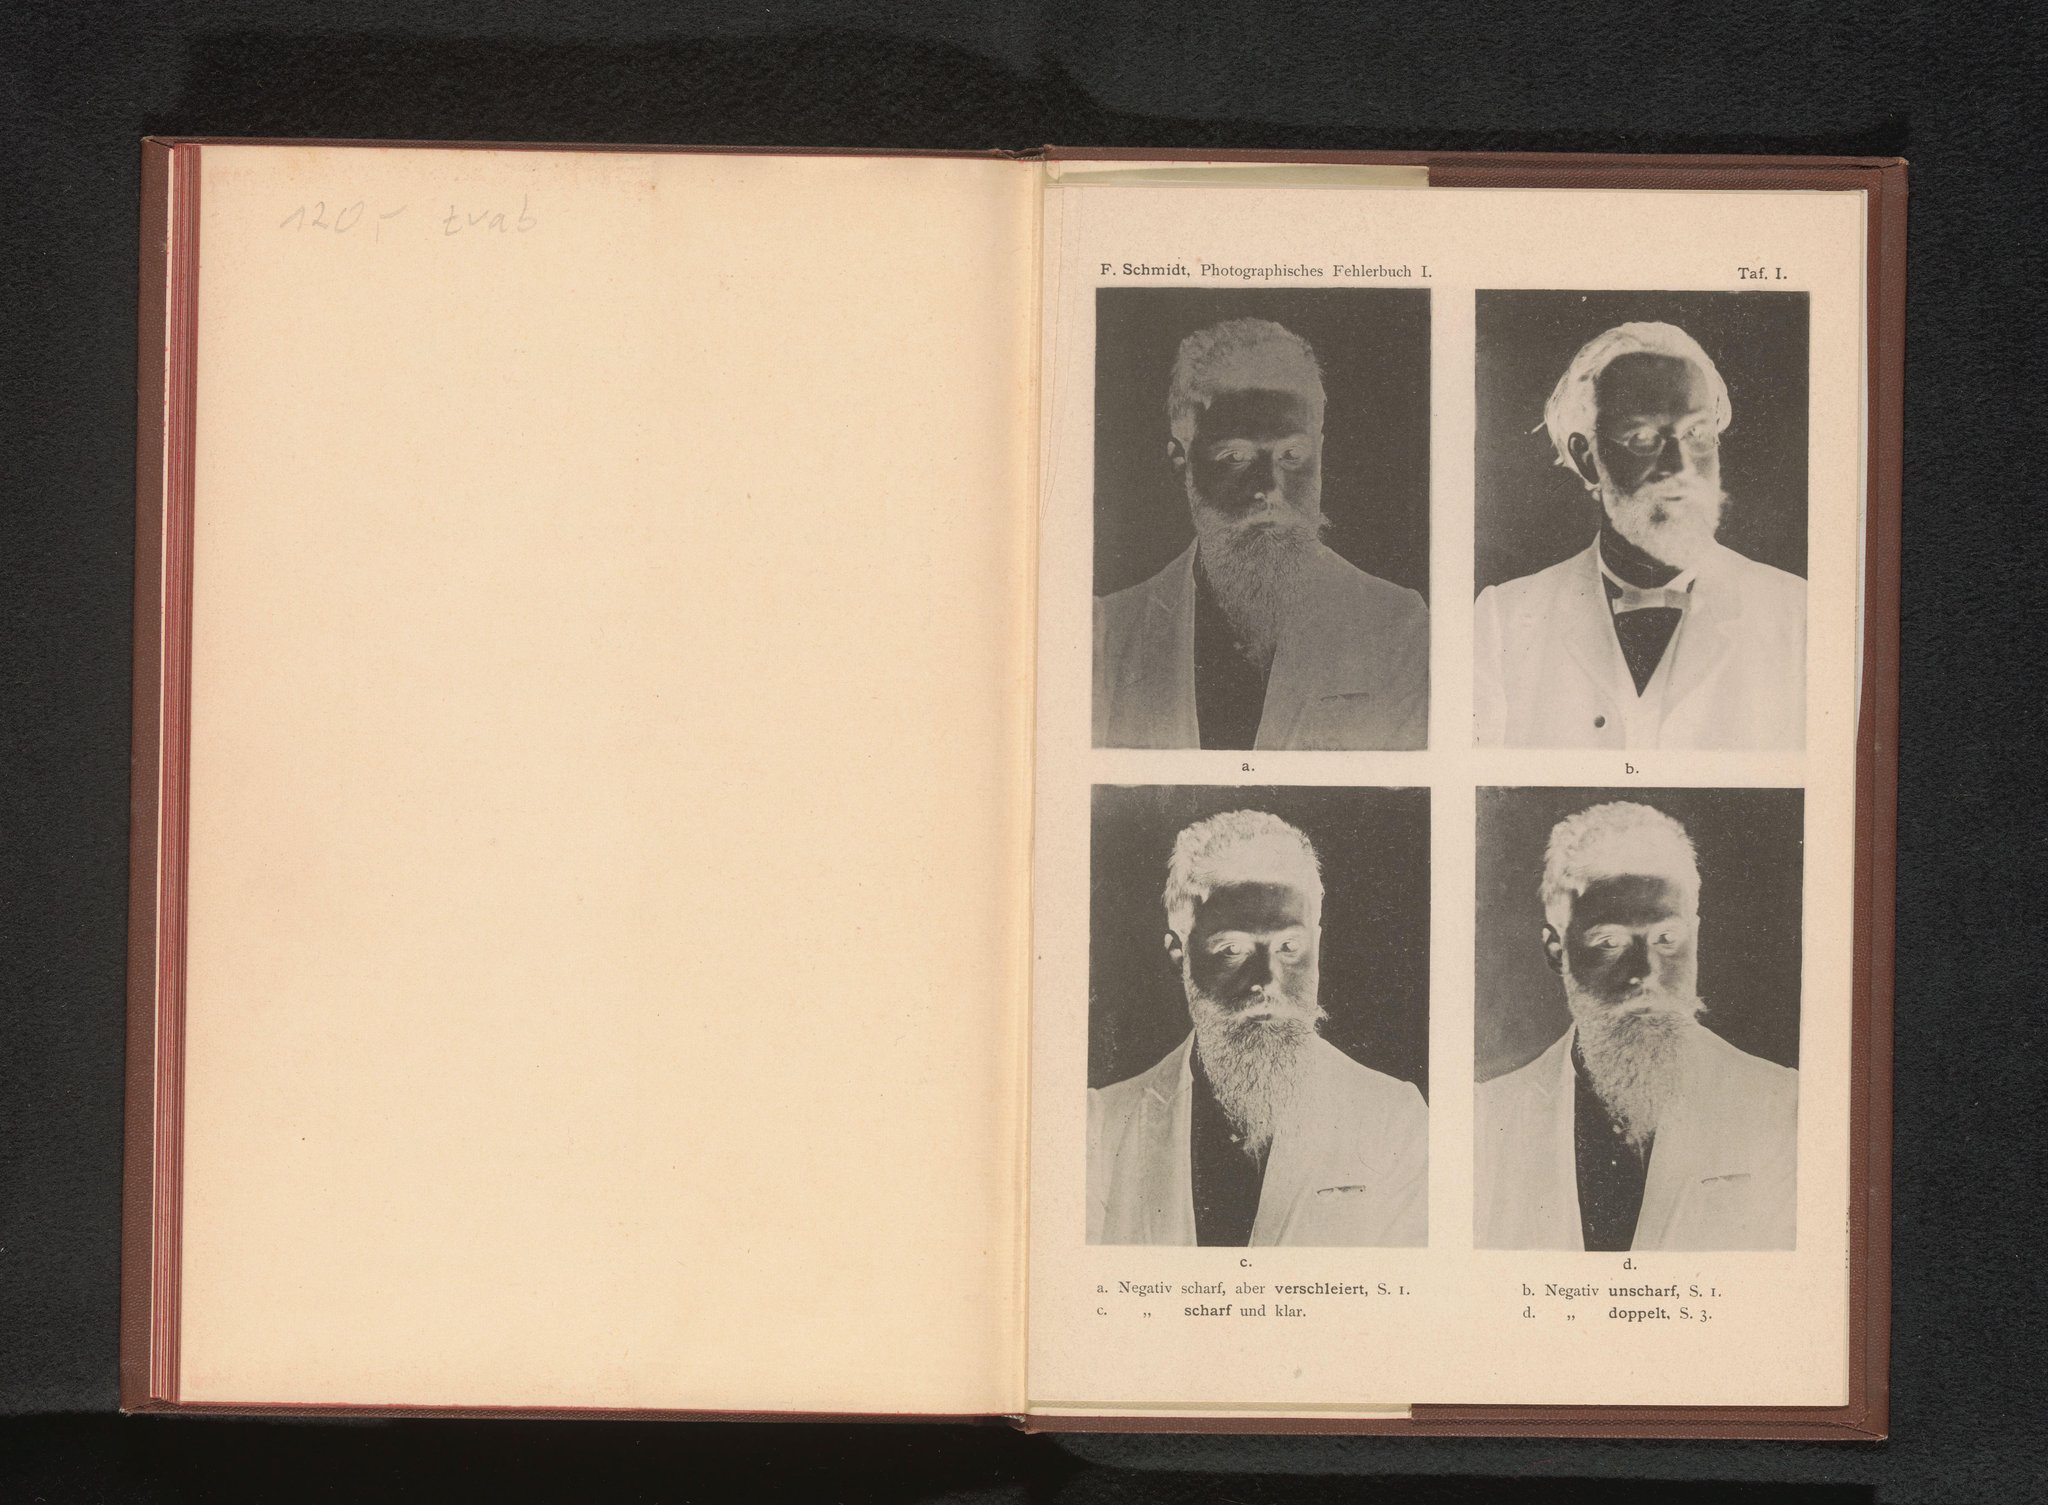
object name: page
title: Drie voorbeelden van een onjuist belicht negatief en een voorbeeld van een juist belicht negatief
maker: Anonymous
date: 1890-1895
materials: paper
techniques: photograph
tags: negative ~ photography, adult man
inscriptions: inscription: ‘a. b./ c. d./ a. Negativ scharf, aber verschleiert, S. 1. b. Negativ unscharf, S. 1./ c. ,, scharf und klar. d. ,, doppelt, S. 3.’, number: ‘Taf. I.’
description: Prenten op losse bladen. Bladen in insteekhoes achterin boek.